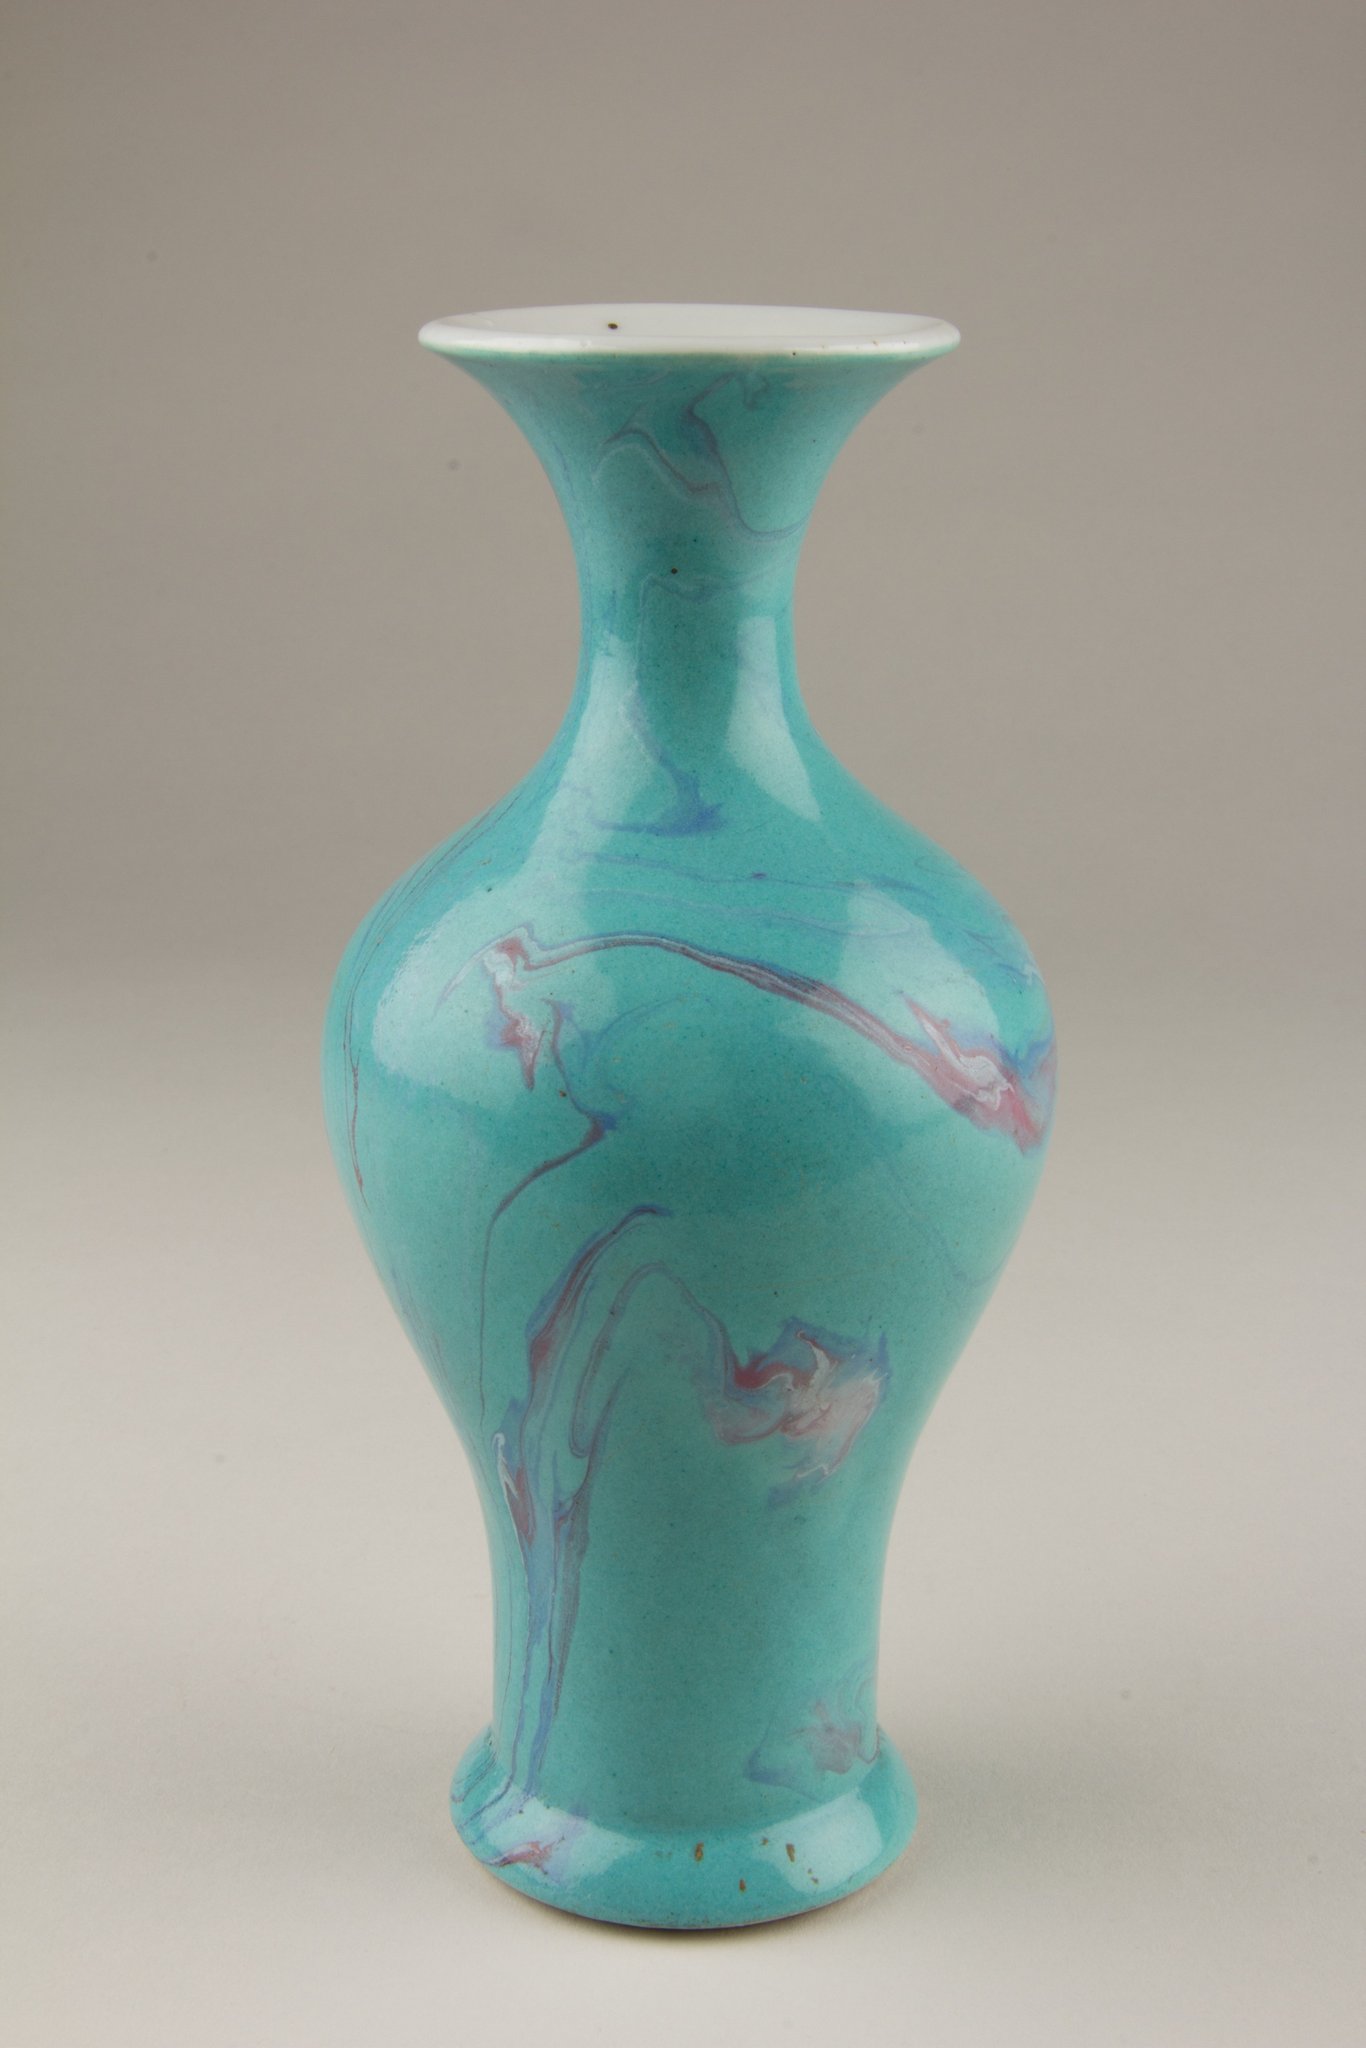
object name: vase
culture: chinese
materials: glaze, marble, porcelain